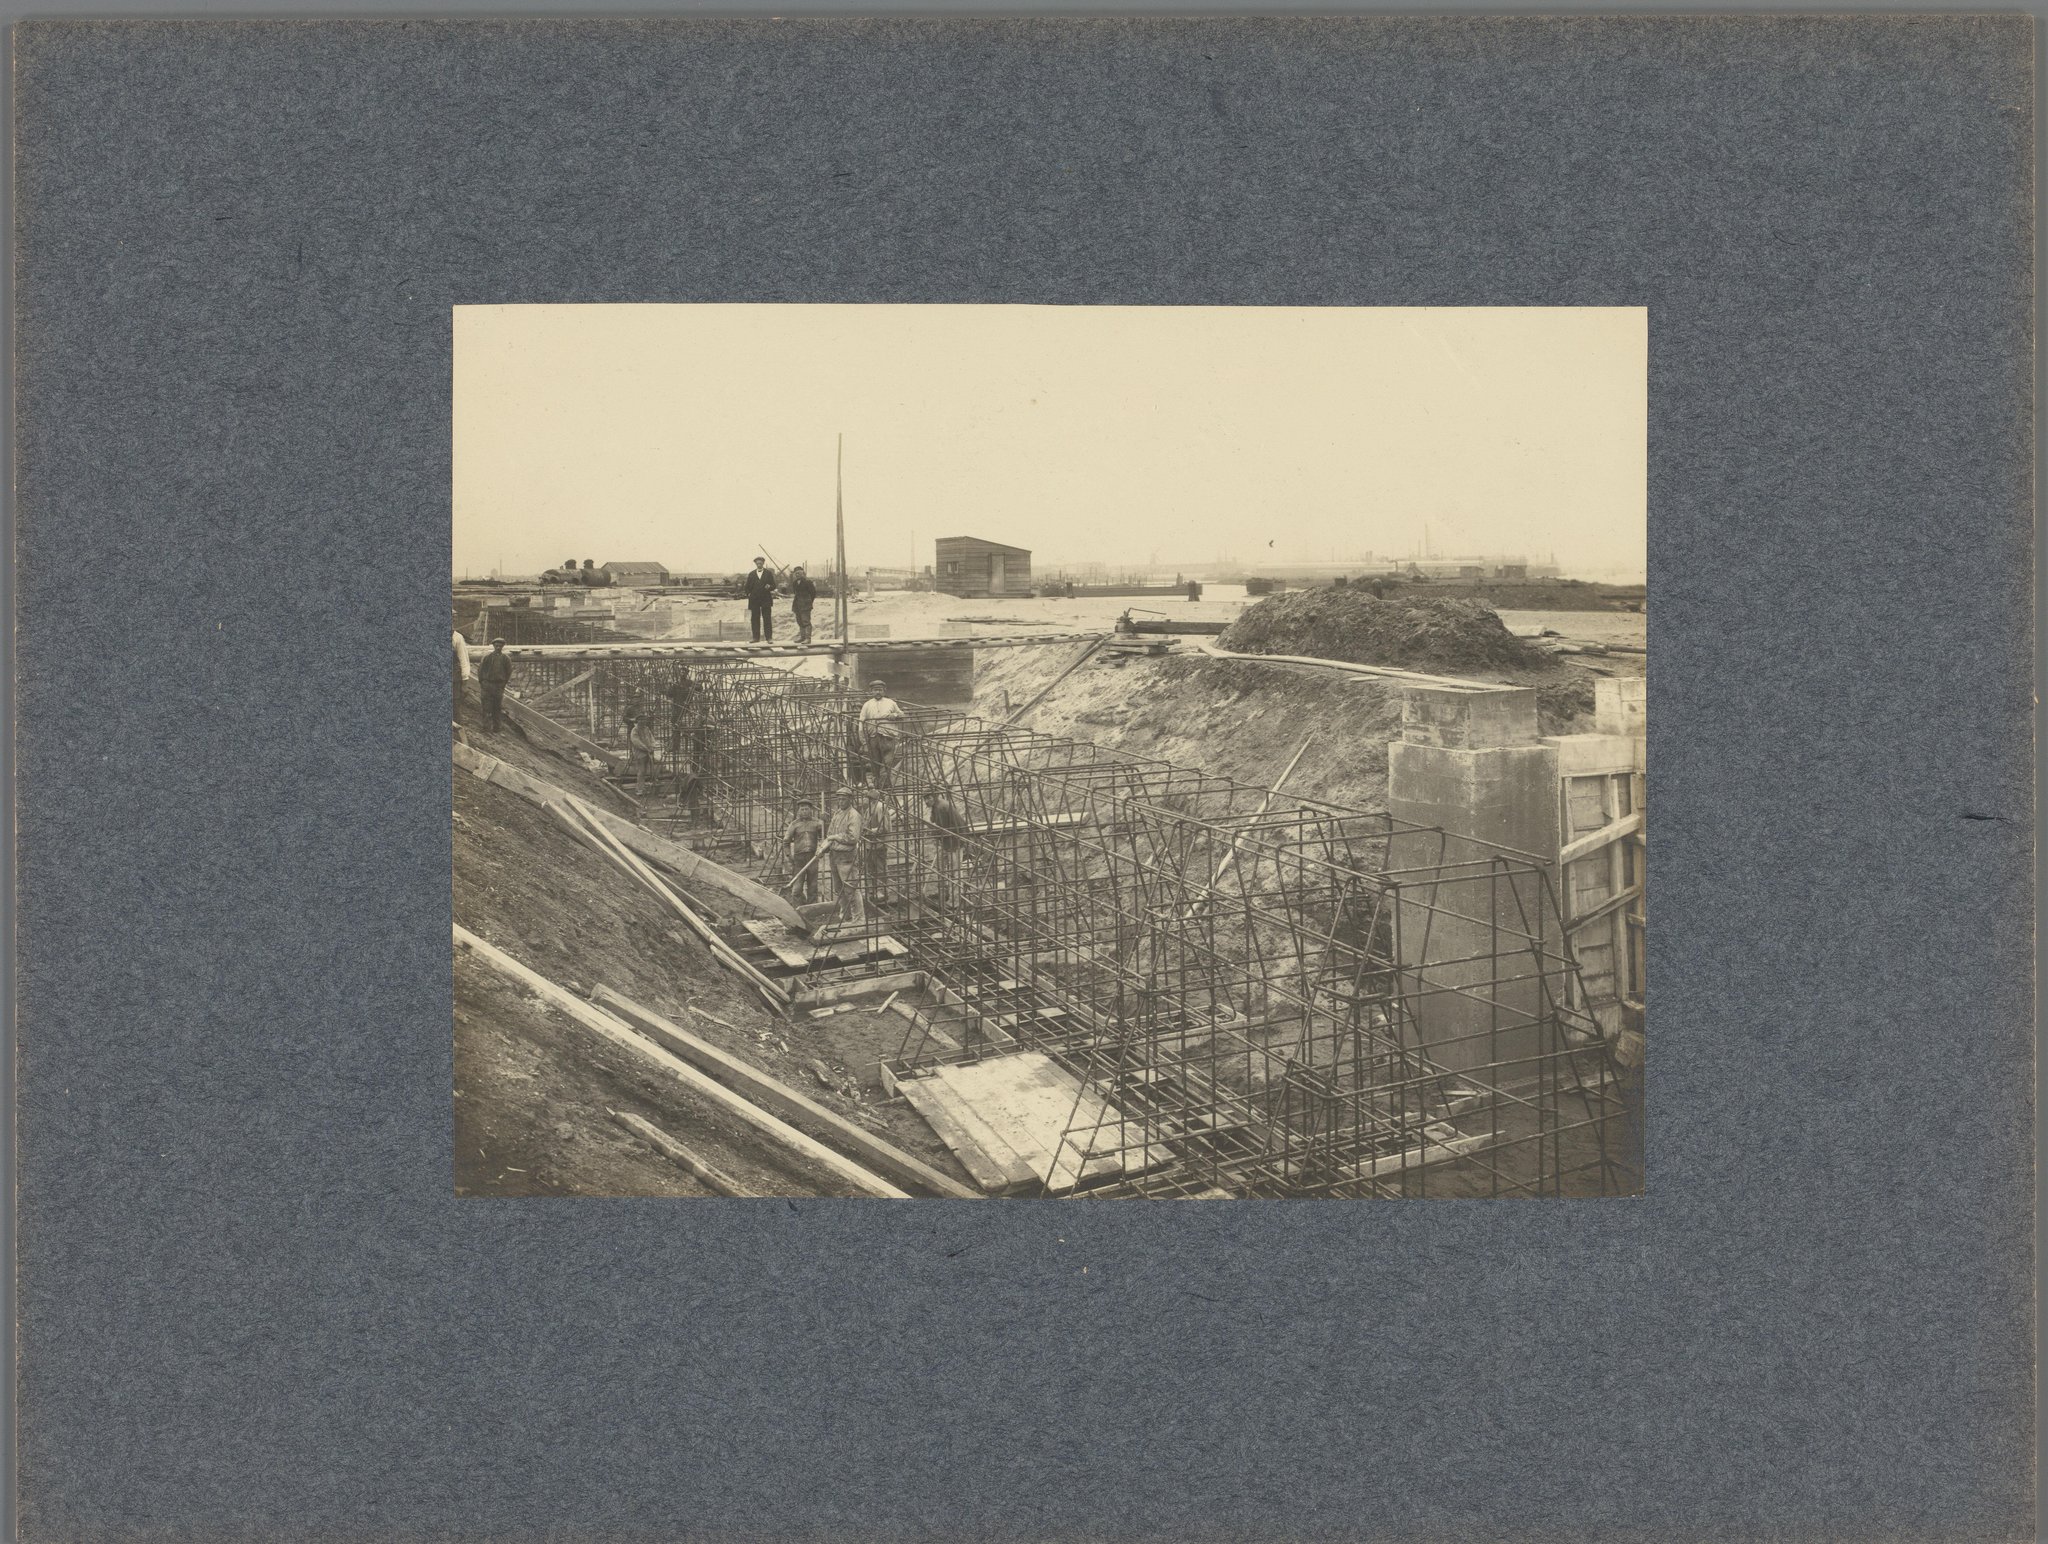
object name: photograph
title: Stalen bewapening in de fundering voor een kolenopslagplaats, Keilehaven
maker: willem sr. bleuzé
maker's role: fotograaf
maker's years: 1873-1948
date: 1912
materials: paper, cardboard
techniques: gelatin silver print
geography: rotterdam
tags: factory-building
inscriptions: address: ‘W. BLEUZÉ/ ROTTERDAM/ JONKER FRANSSTRAAT 66’, inscription: ‘Zuid fundering/ kolenopslagkraan/ Gasfabriek v/d Keilehaven’